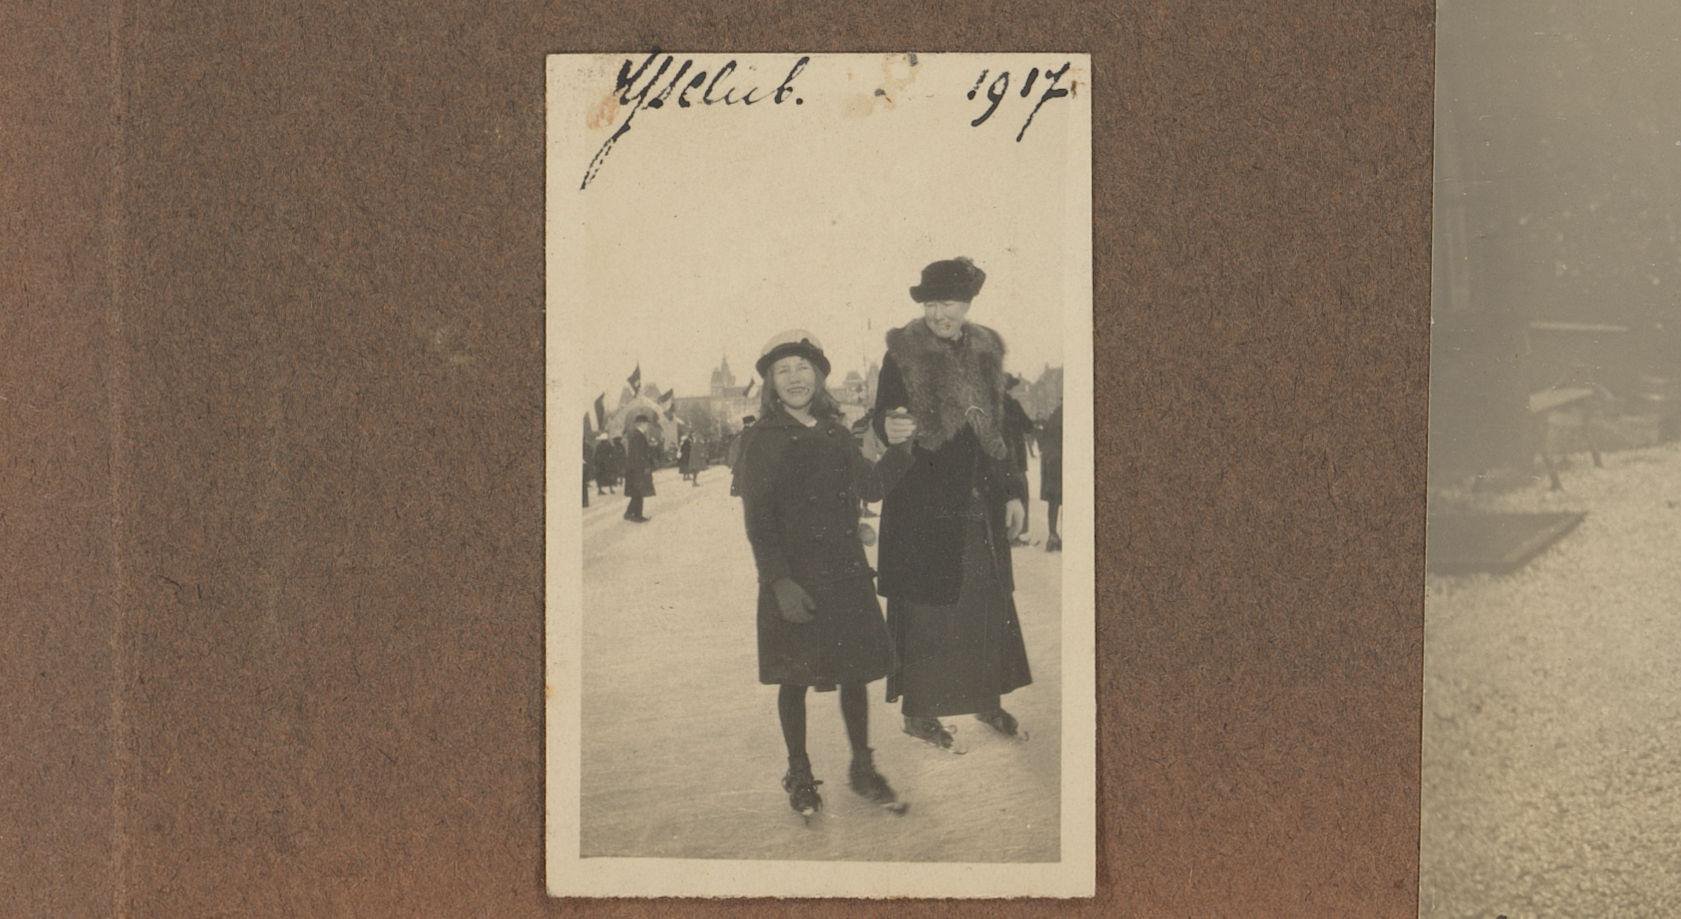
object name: photograph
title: IJsclub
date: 1917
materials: photographic support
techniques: photography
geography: netherlands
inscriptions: inscription: ‘IJsclub . 1917’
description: Foto op bruin albumblad 27 van familiealbum van Alphons Diepenbrock.